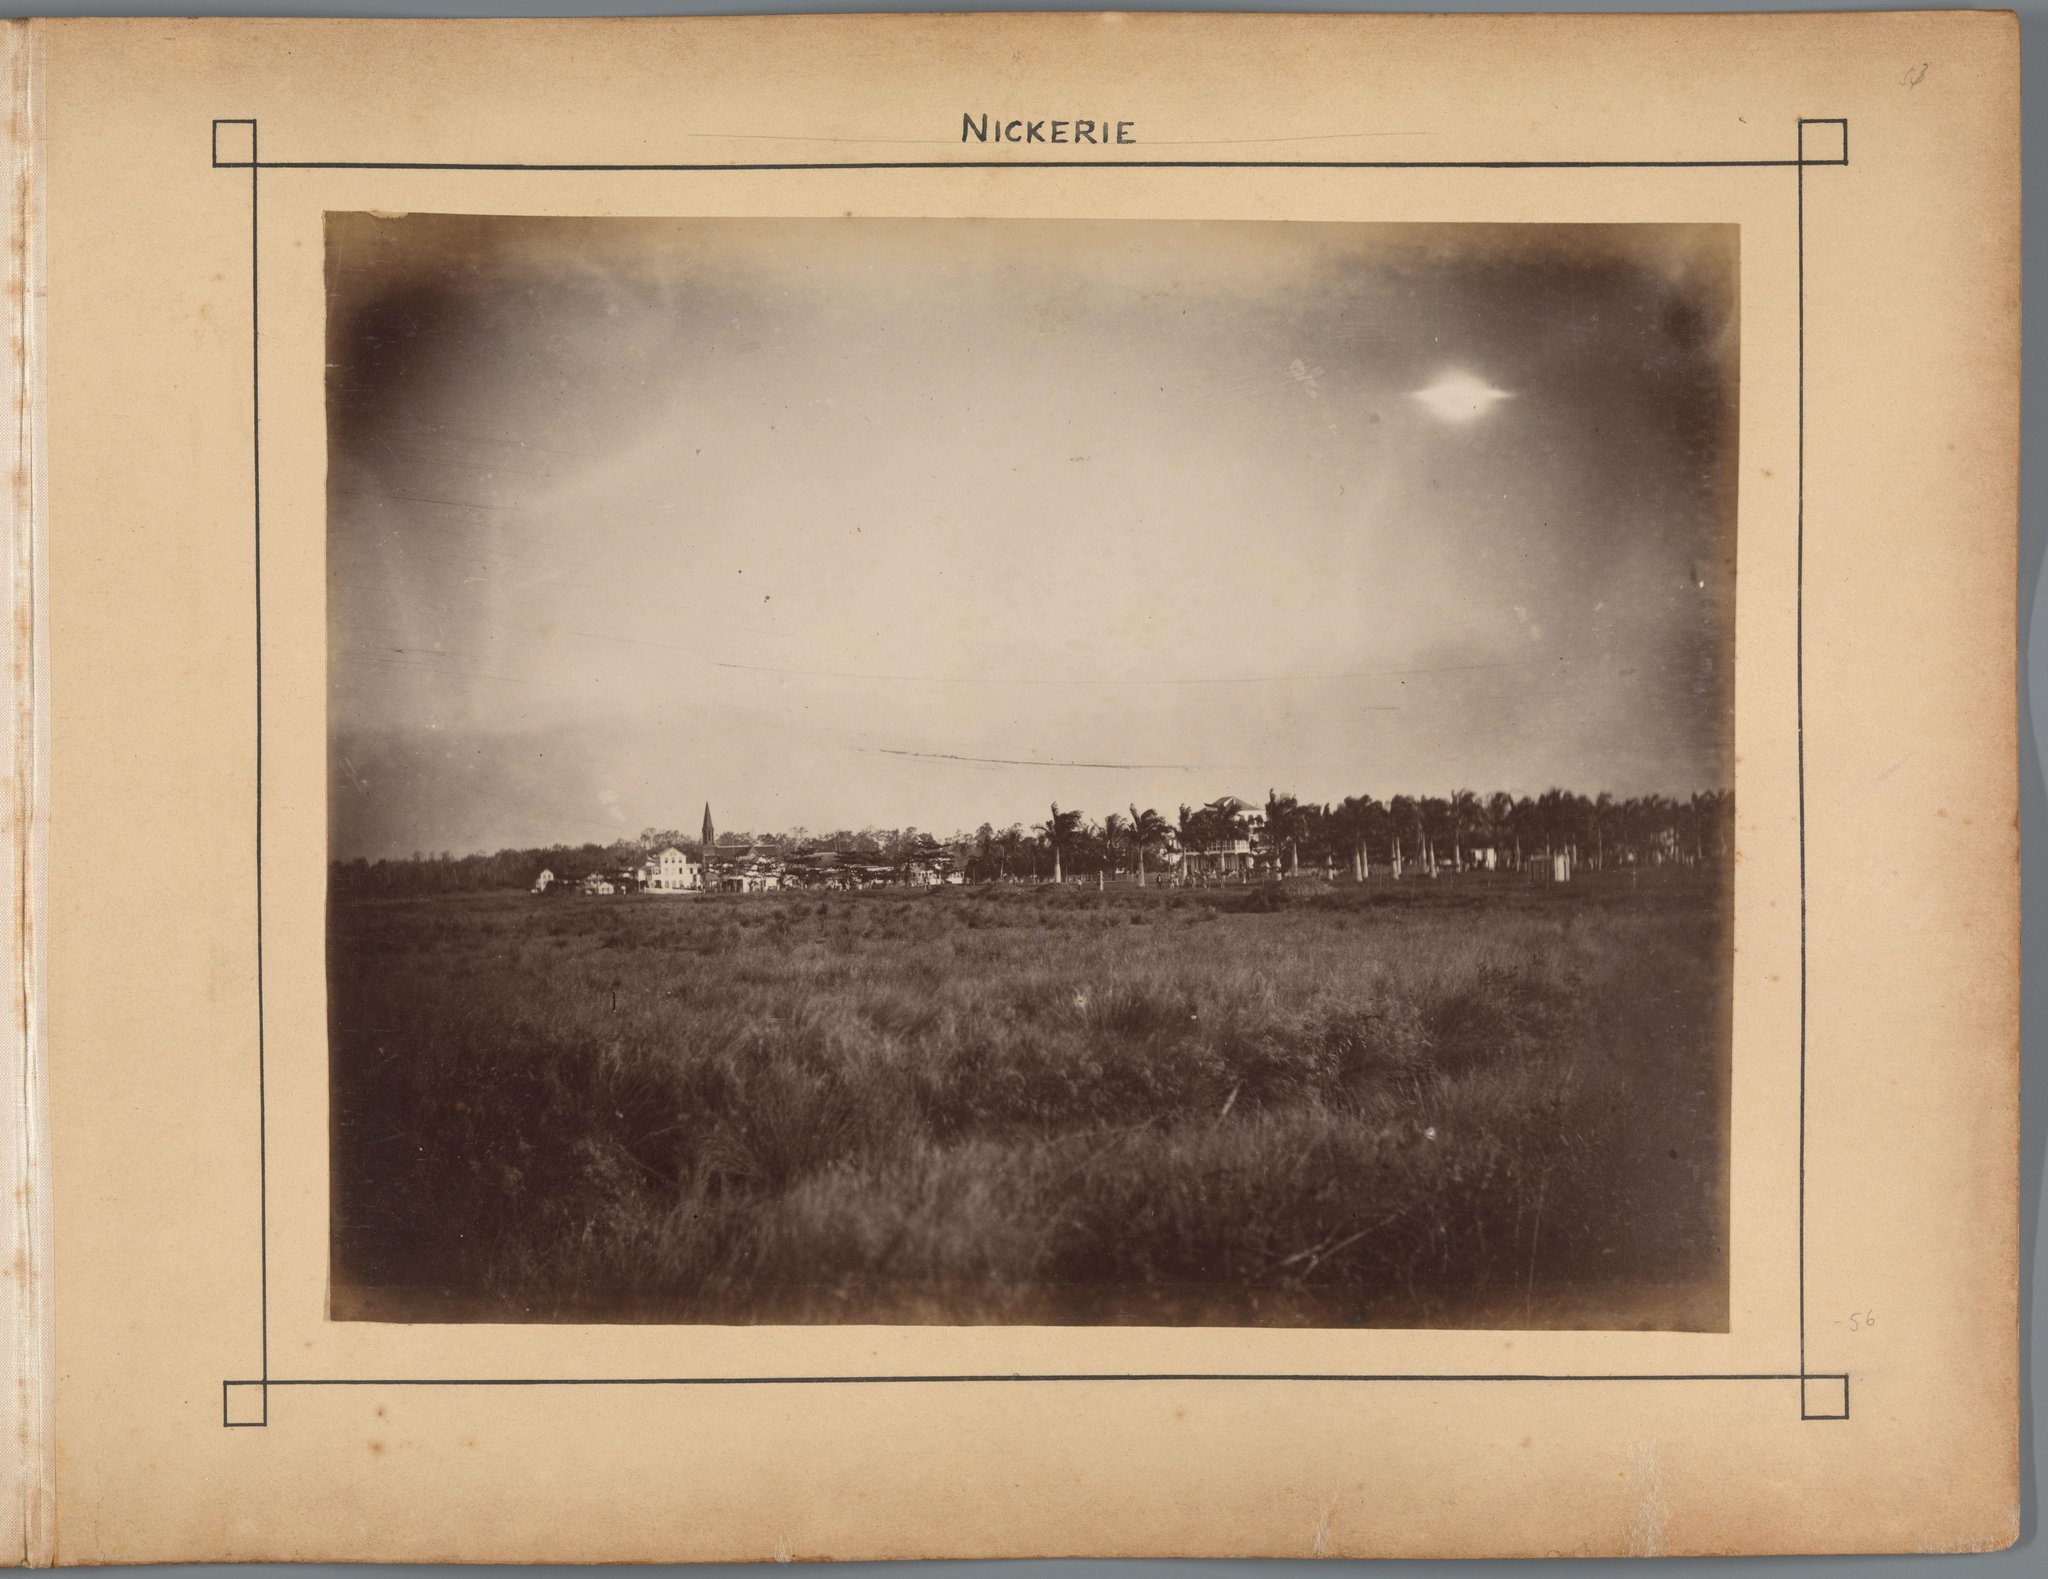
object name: photograph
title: Nickerie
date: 1898-1902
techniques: albumen print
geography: suriname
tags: suriname